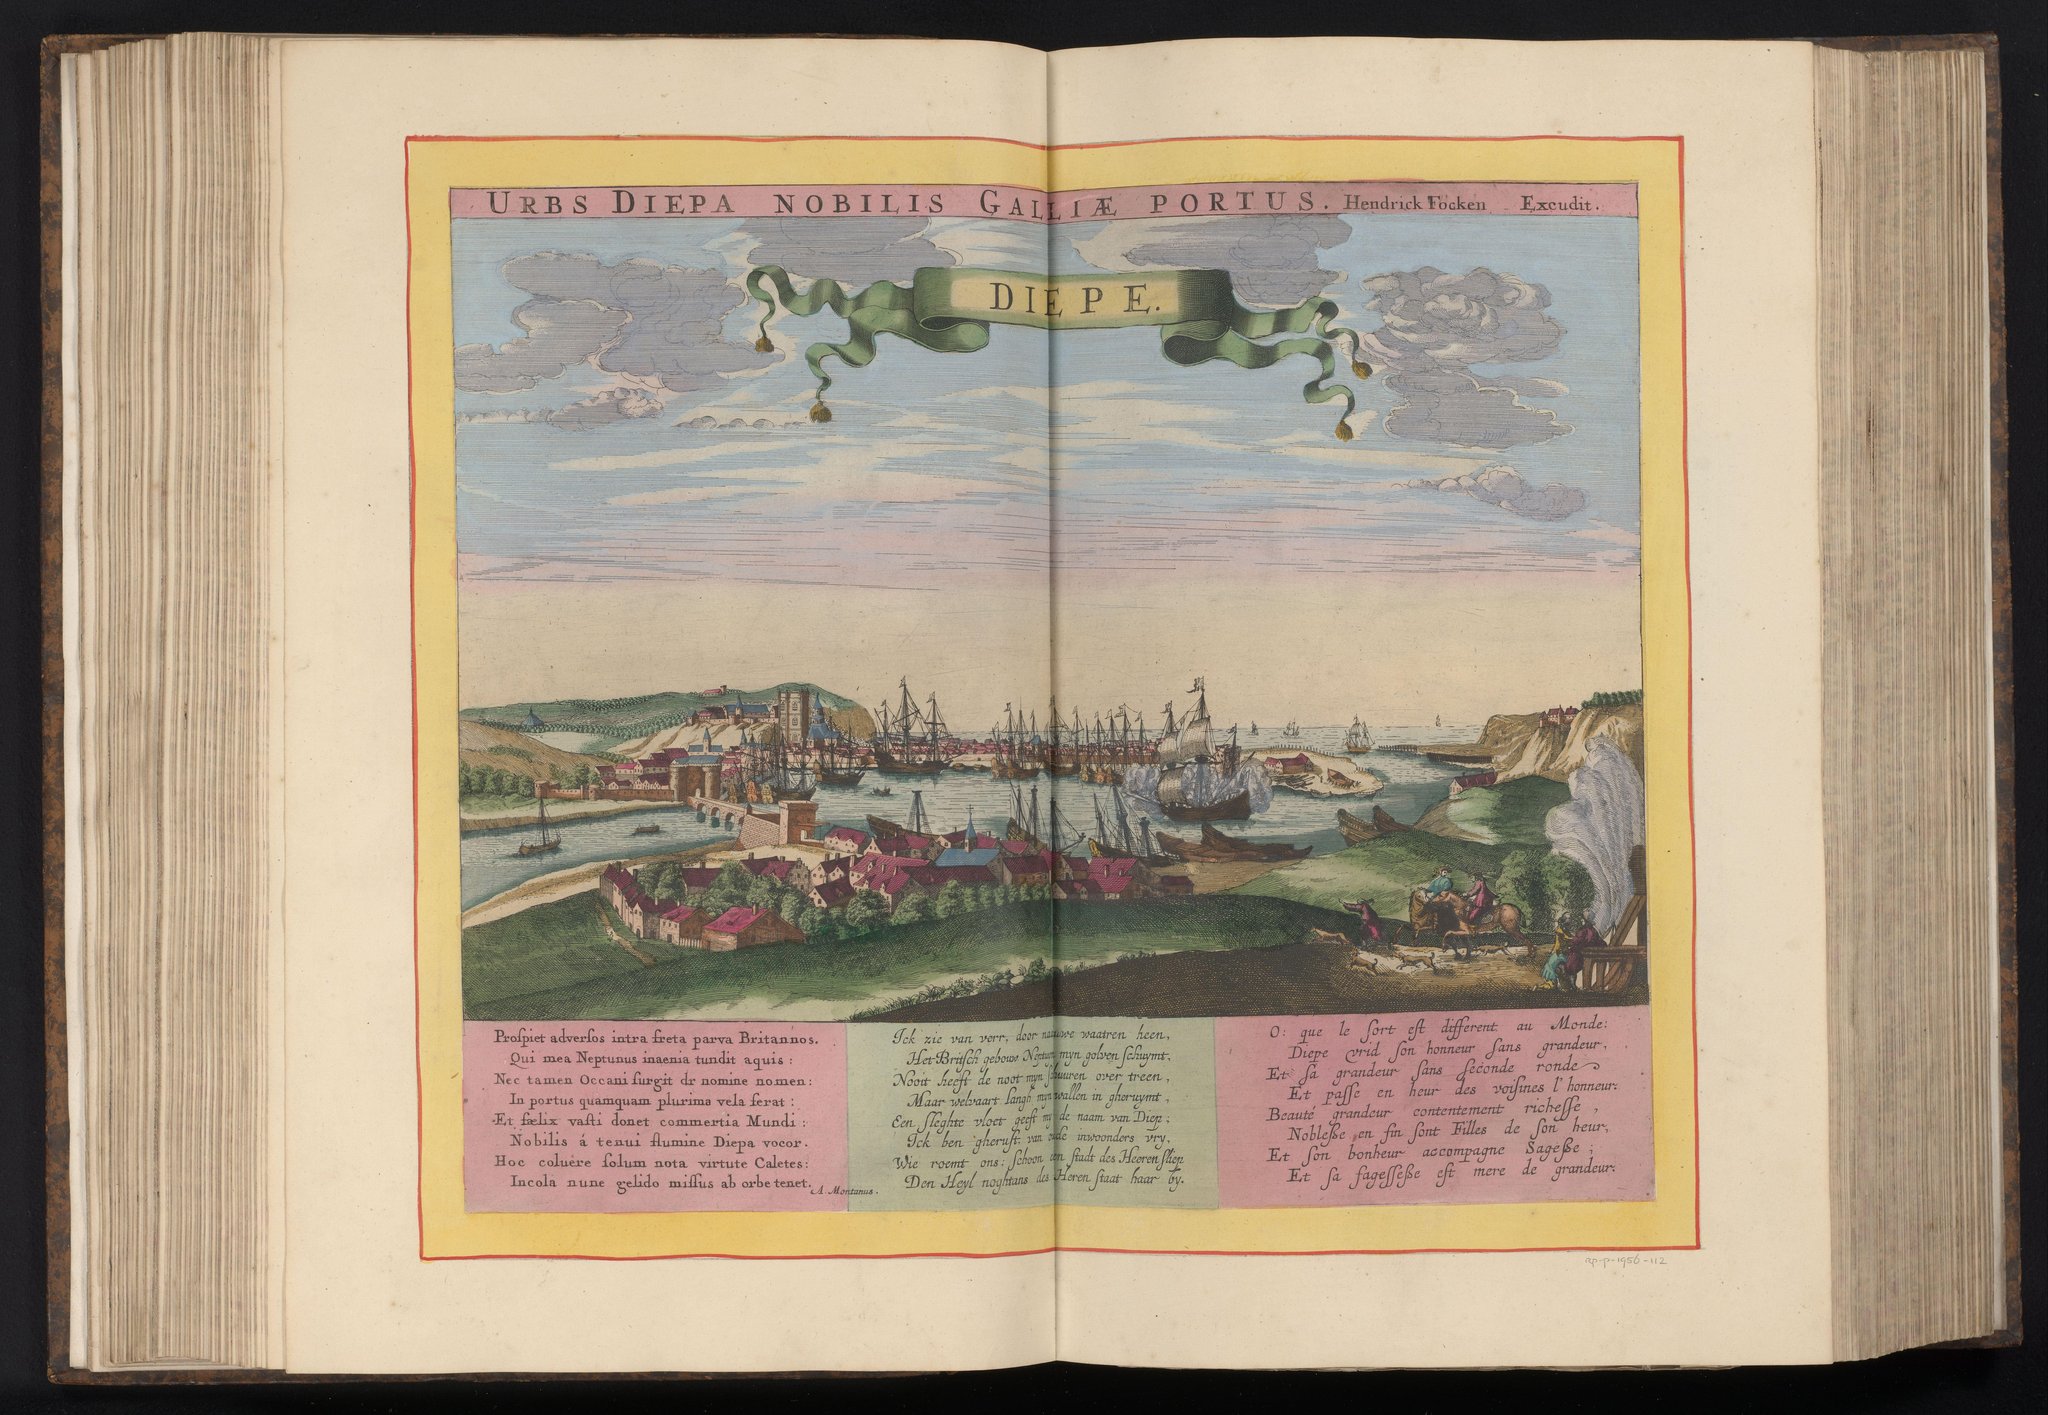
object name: print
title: Diepe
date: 1665-1689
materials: paper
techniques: engraving, etching, hand coloring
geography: the hague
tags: city-view in general; 'veduta'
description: Onder de prent in achtregelig gedicht in het Latijn, Nederlands en Frans. Deze prent maakt deel uit van een album.